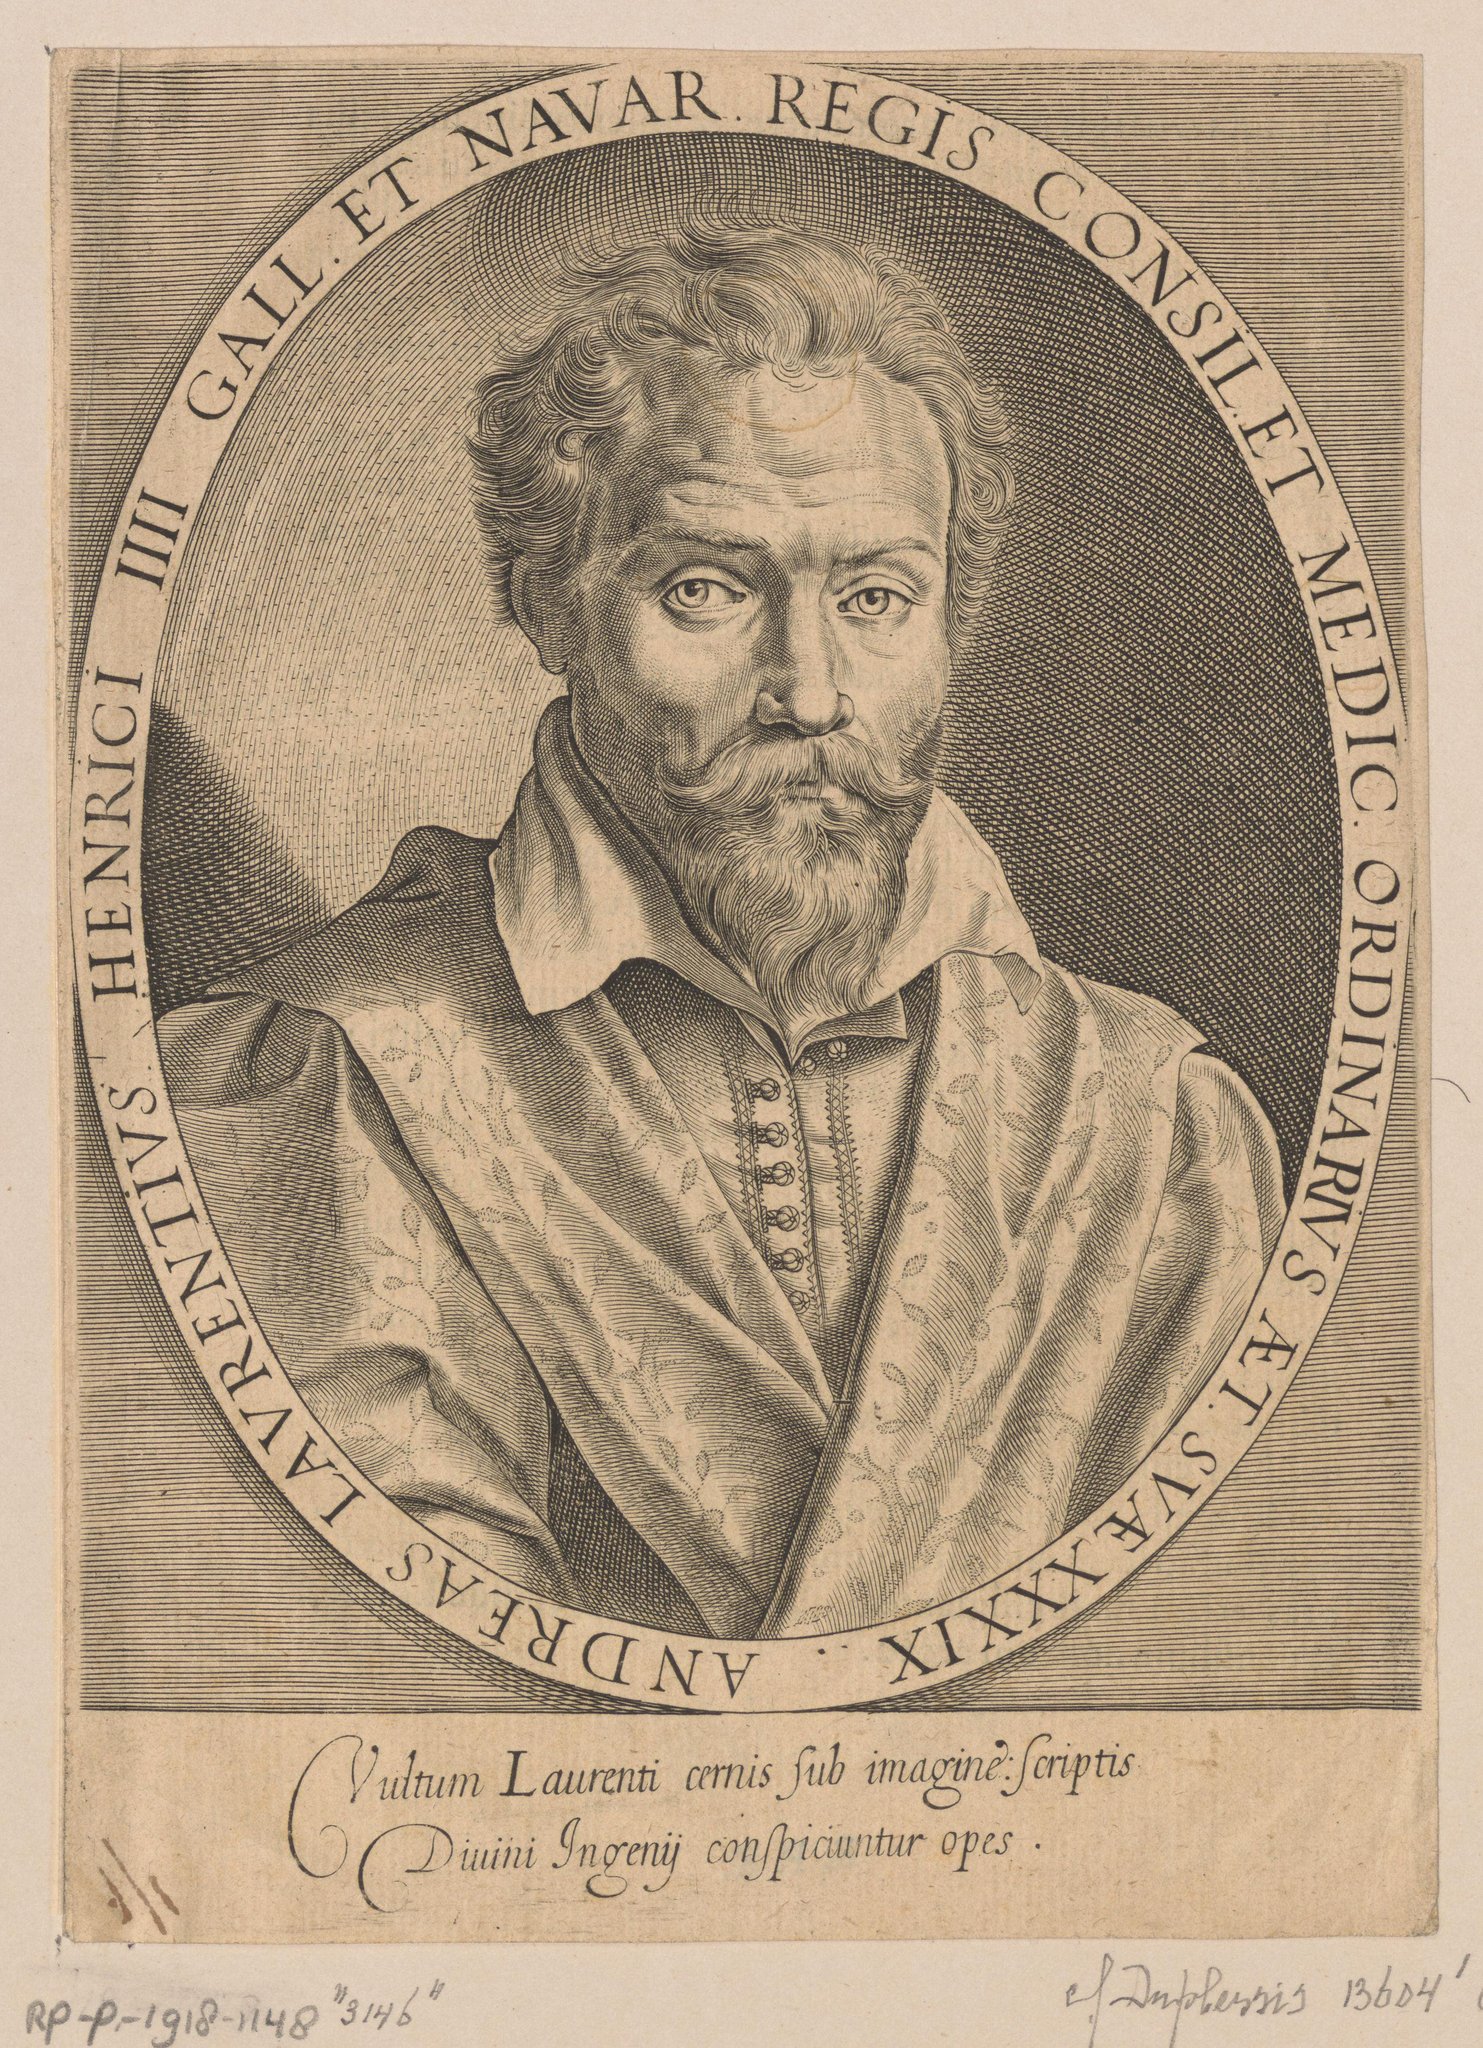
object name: print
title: Portret van André du Laurens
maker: Anonymous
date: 1613-1621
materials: paper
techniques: engraving, letterpress printing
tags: historical persons, physician, doctor (+ portrait of scholar, scientist)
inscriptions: collector's mark: Lugt 2233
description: De prent komt uit een onbekende publicatie. Met andere tekst op verso is de prent gebruikt in: Laurens, André du. Toutes les Oeuvres de M. André du Laurens (...). Parijs: Raphael du Petit, 1621. Mogelijk is de prent met deze tekst gebruikt in de editie van dit werk uit 1613.